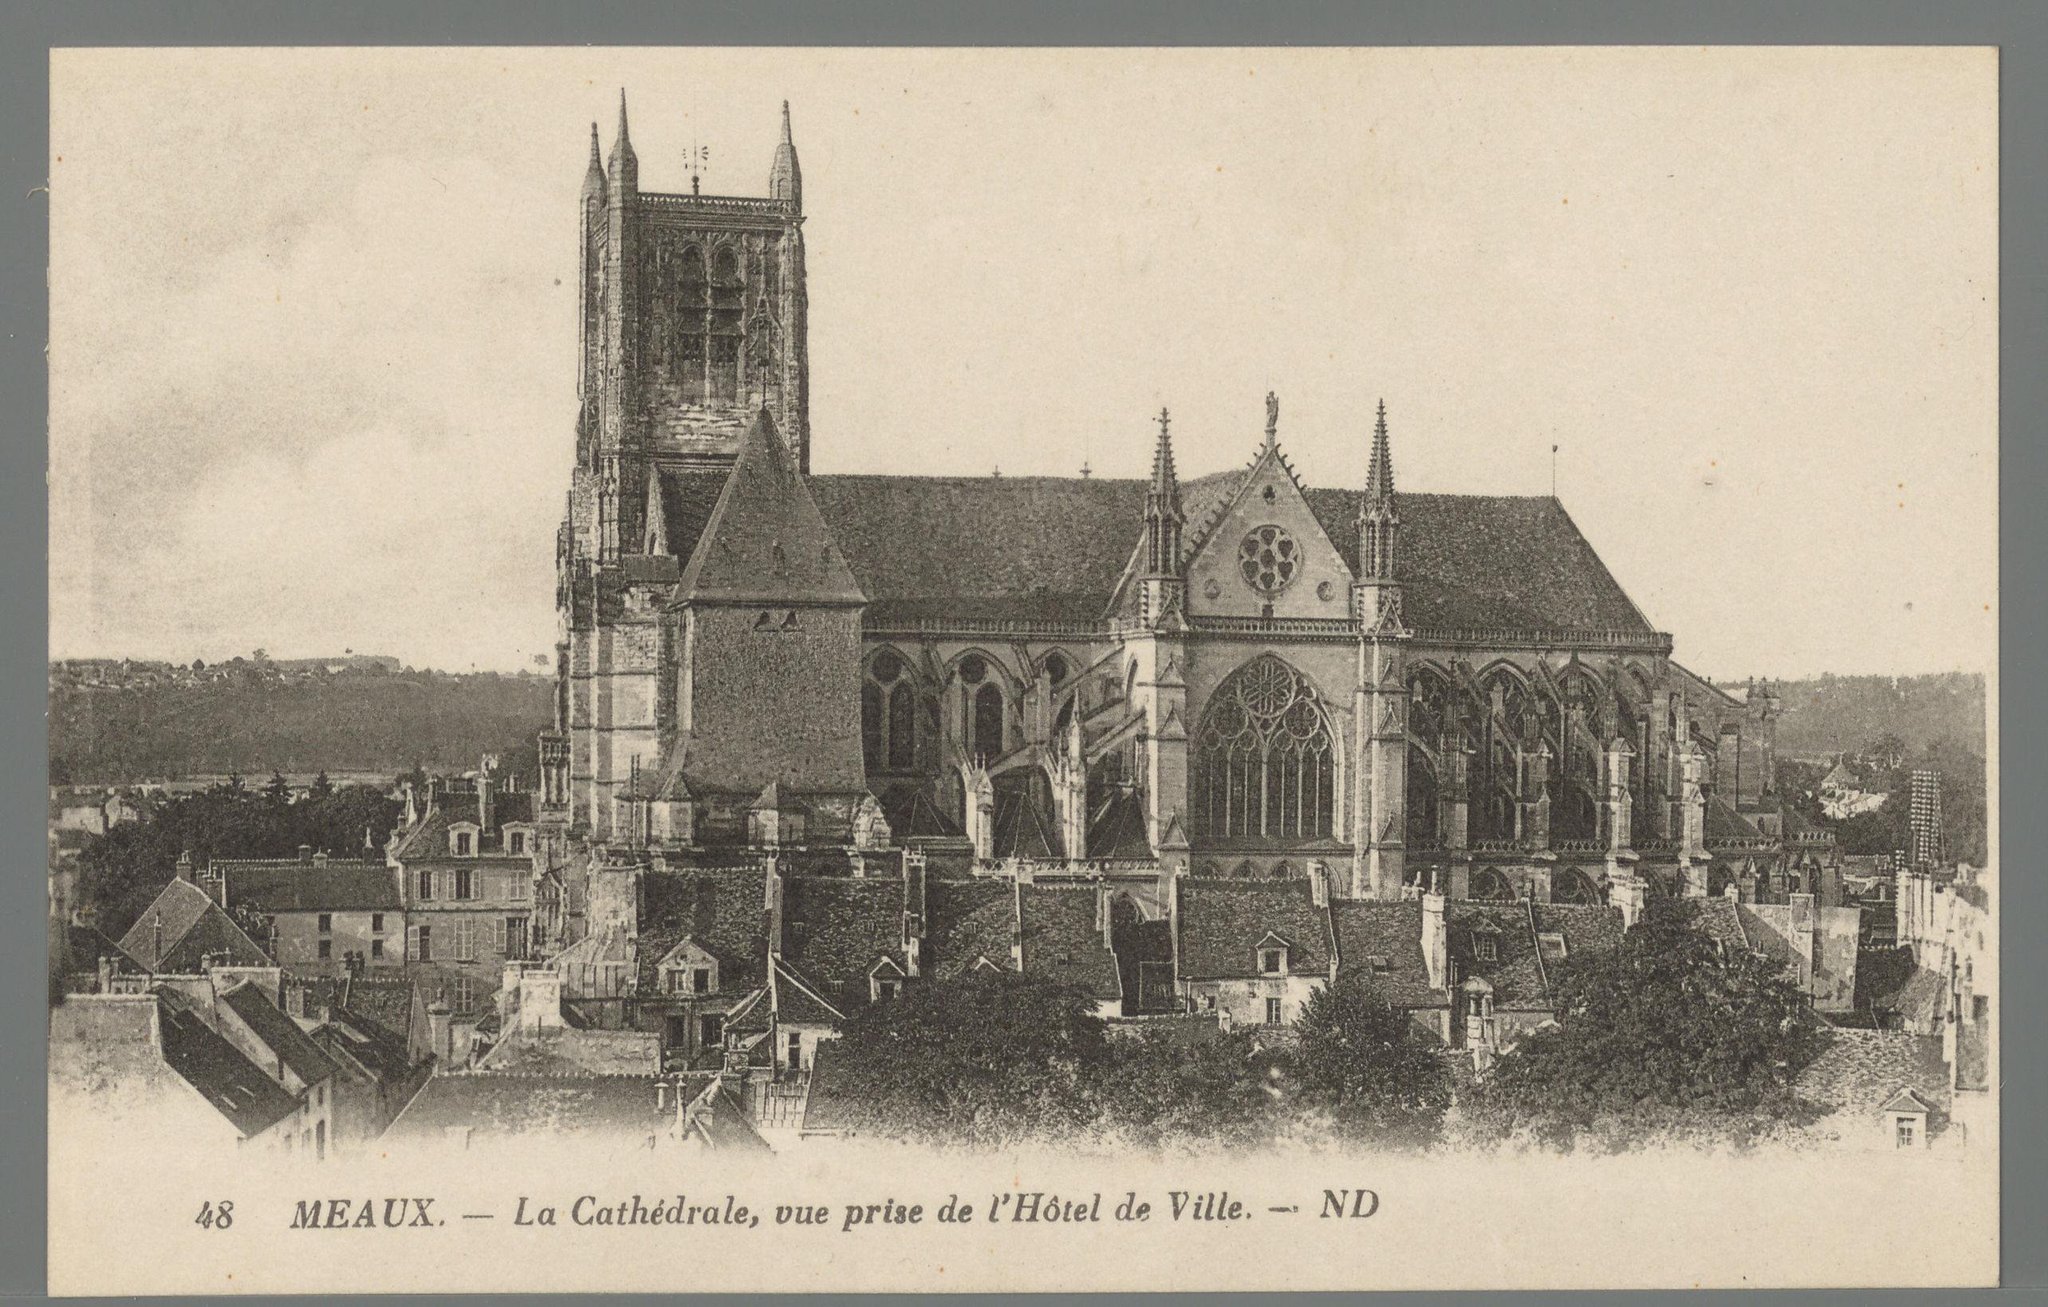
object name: photomechanical print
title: Meaux - La Cathédrale, vue prise de l'Hôtel de Ville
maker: Anonymous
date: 1920-1932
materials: cardboard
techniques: photograph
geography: meaux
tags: church (exterior)